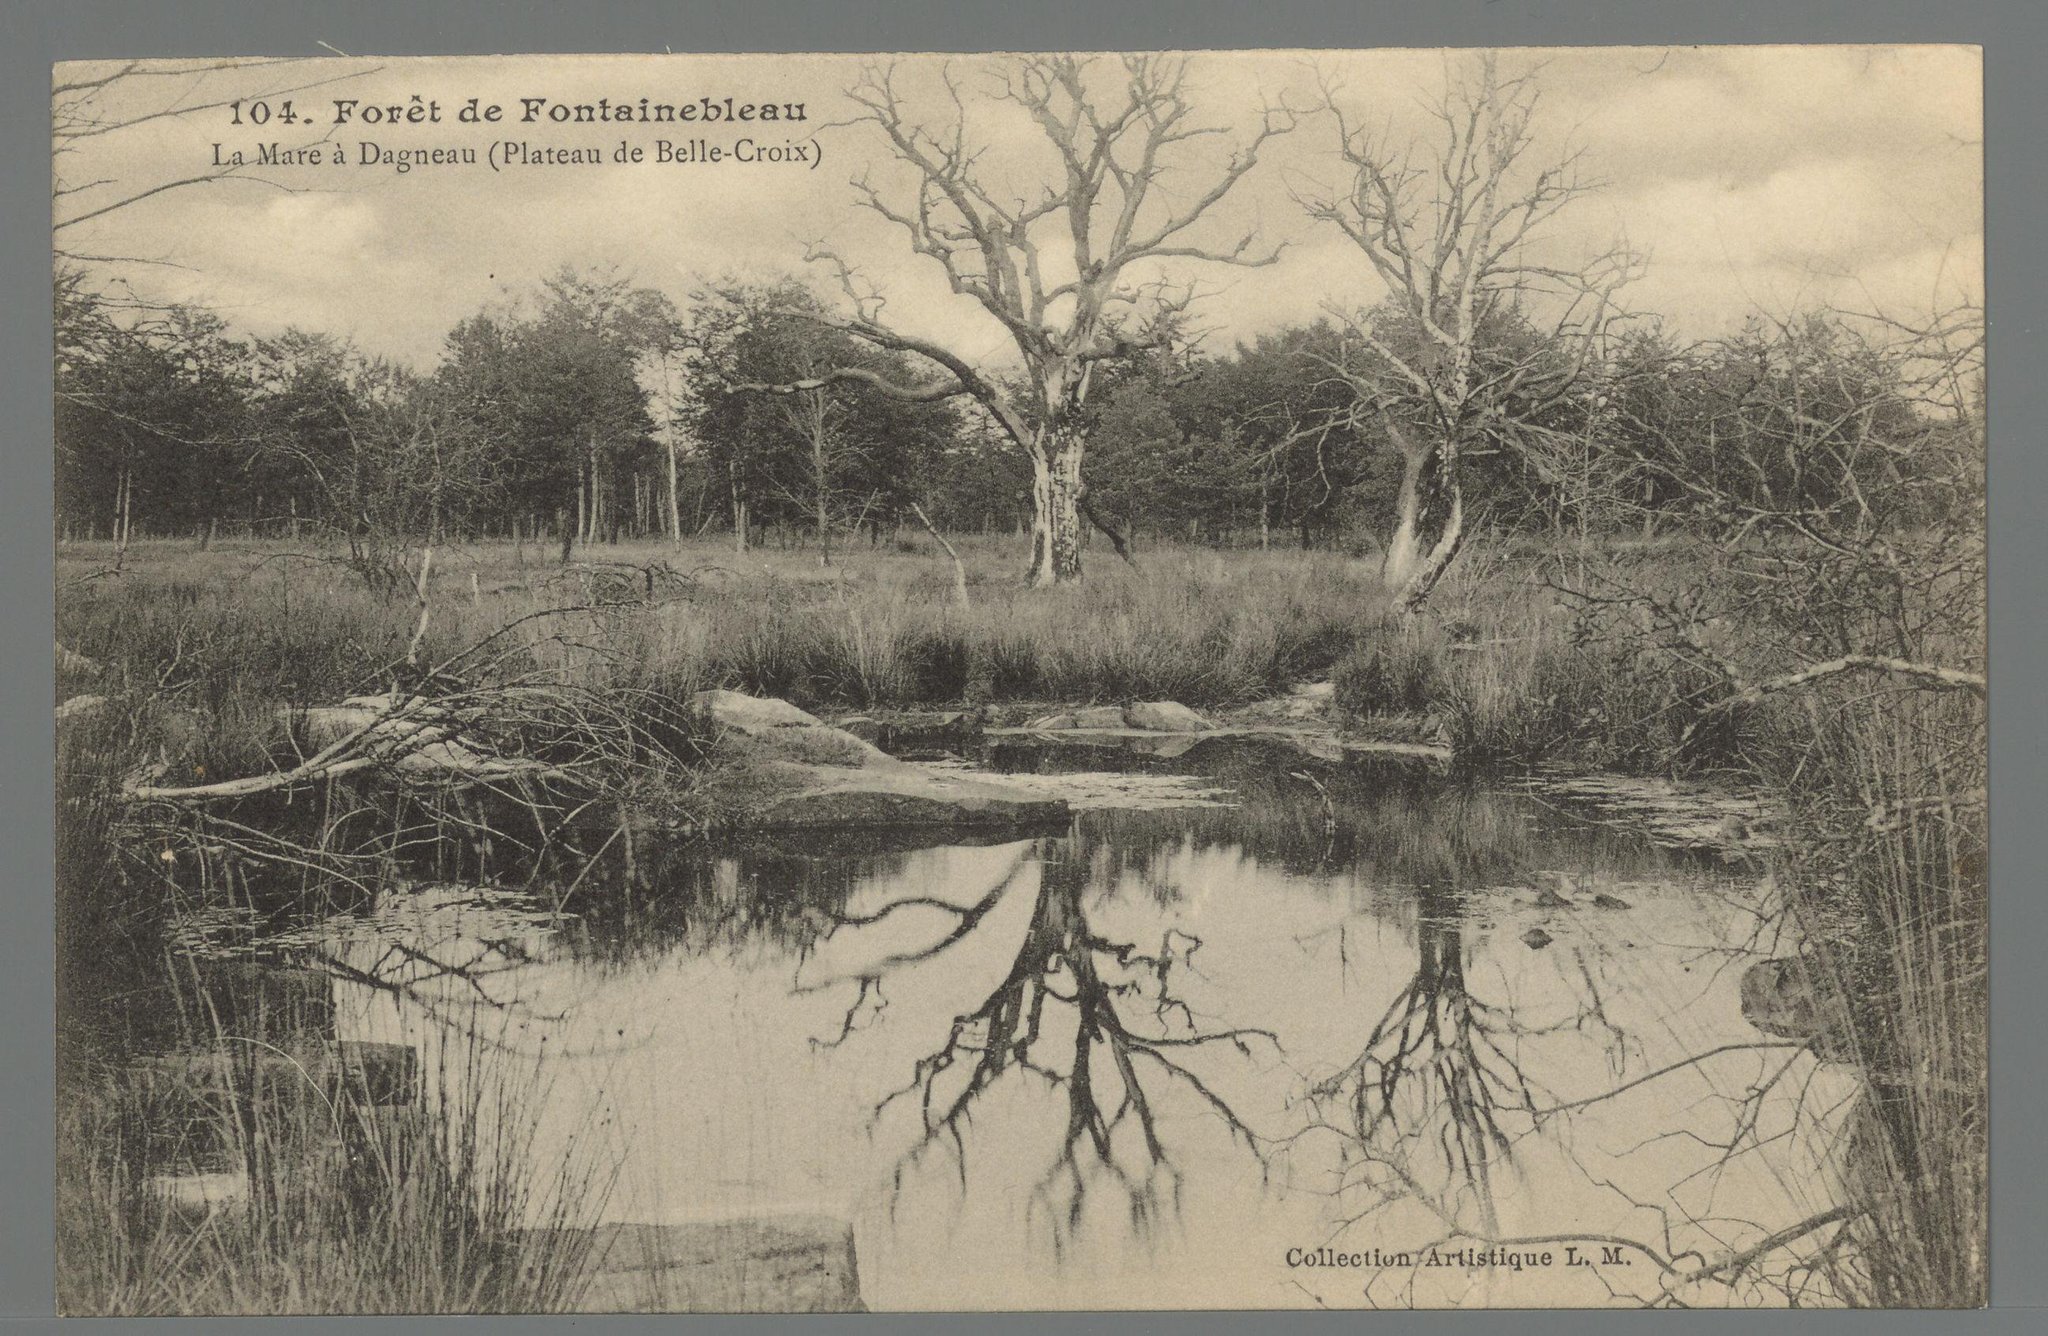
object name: photomechanical print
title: La Mare à Dagneau (Plateau de Belle-Croix)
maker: léon ménard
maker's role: printer, publisher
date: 1903-1920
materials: cardboard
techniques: photograph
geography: fontainebleau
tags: forest, wood, pond, pool